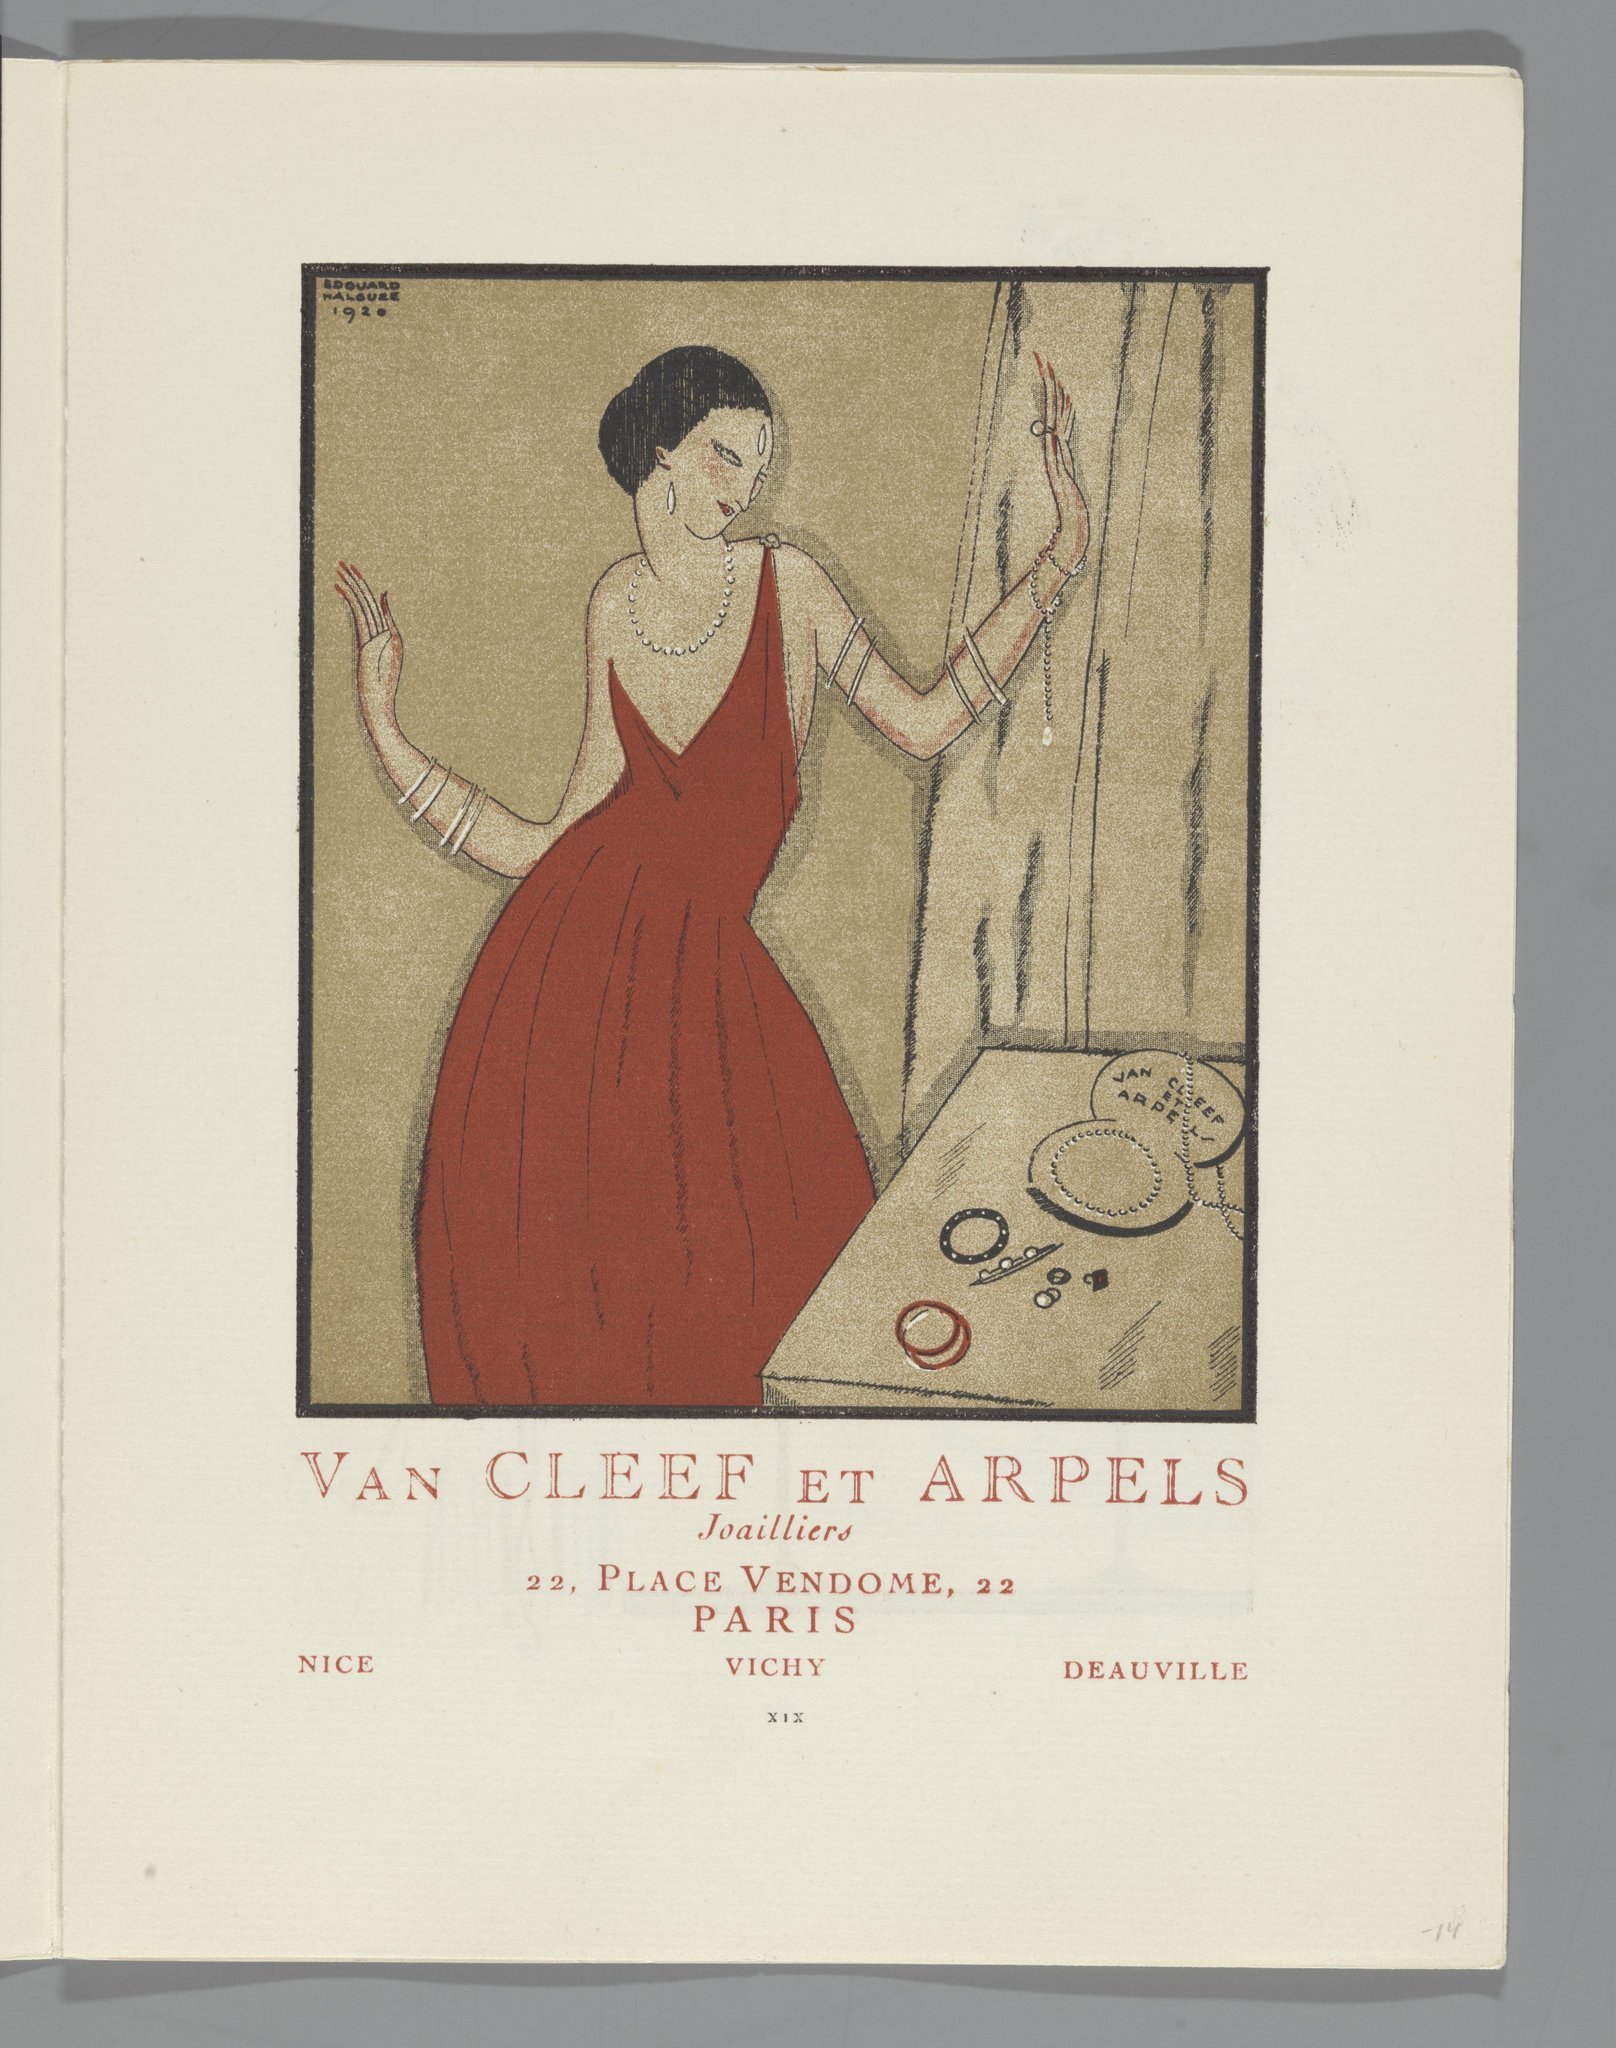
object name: fashion print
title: Gazette du Bon Ton, 1920 - No. 3, p. XIX: Cleef en Arpels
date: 1920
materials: paper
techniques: lithograph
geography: paris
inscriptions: date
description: Advertentie Van Cleef et Arpels, Joailliers 22, Place Vendome, 22 Paris. Dame in rode avondjapon, met oorbellen, parelsnoer, armbanden, staand bij een tafel waarop juwelen.